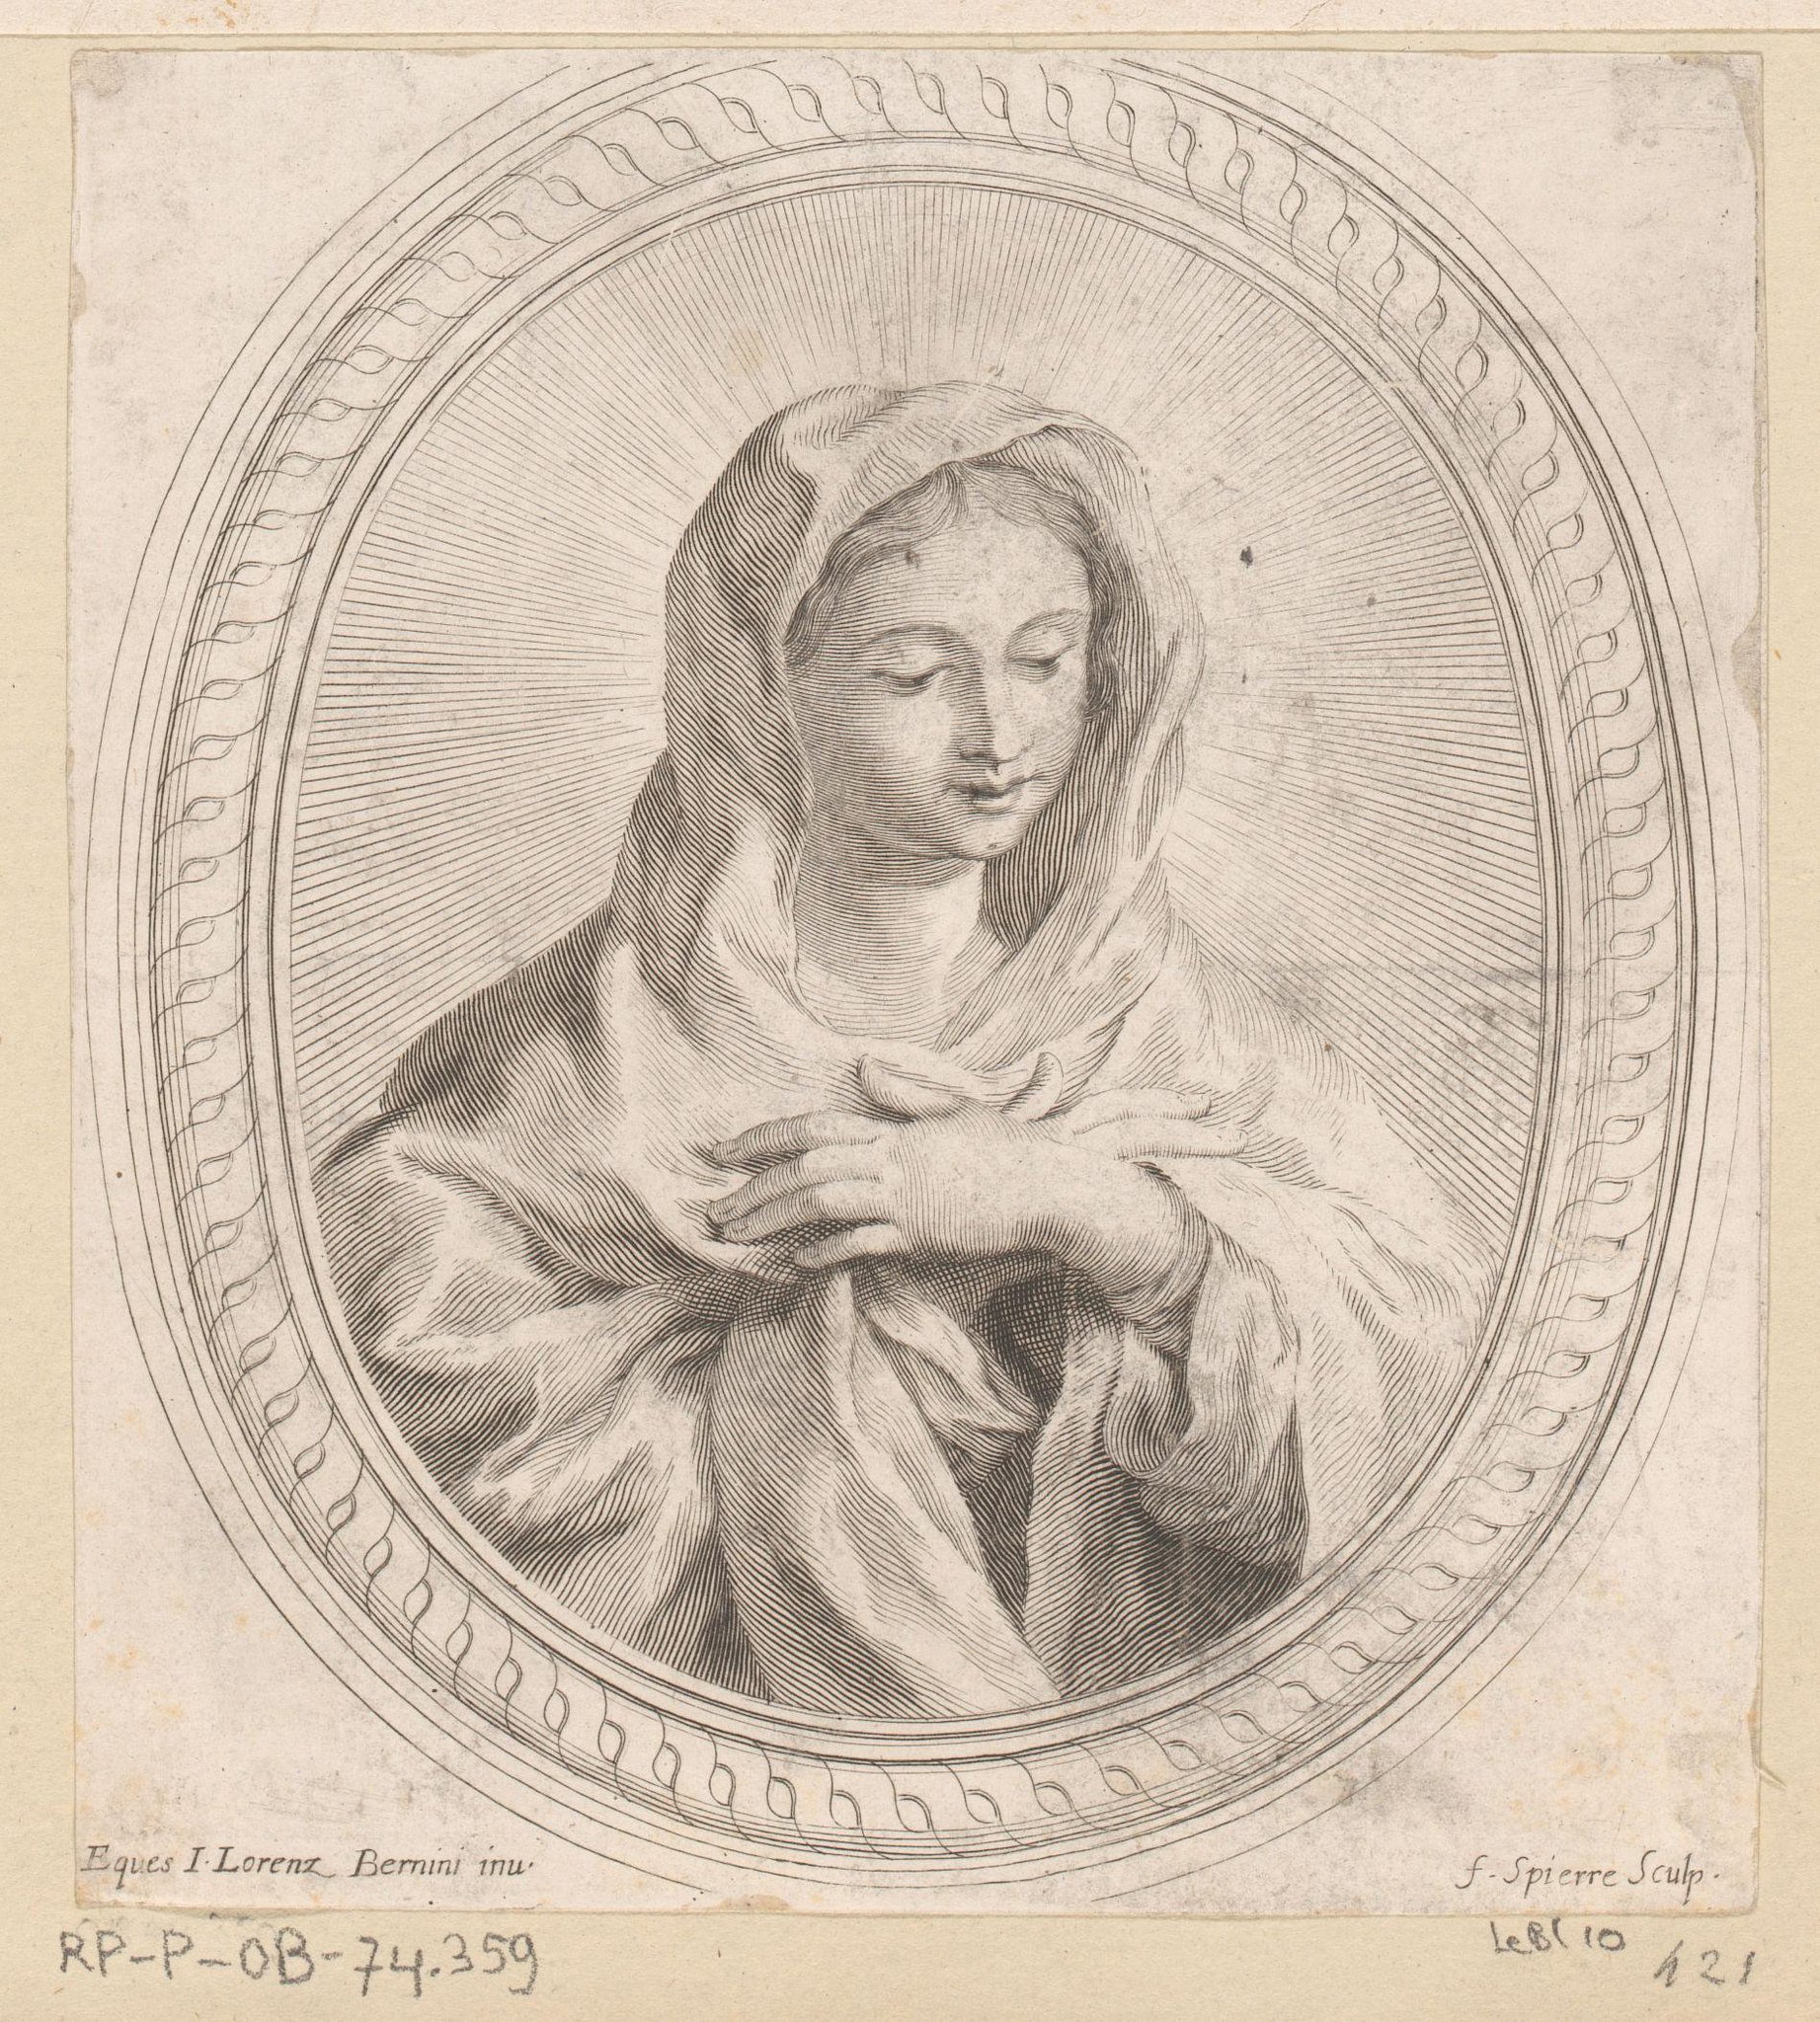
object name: print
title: Maria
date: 1649-1681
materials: paper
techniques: engraving, etching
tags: mary (without the christ-child)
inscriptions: collector's mark: Lugt 240